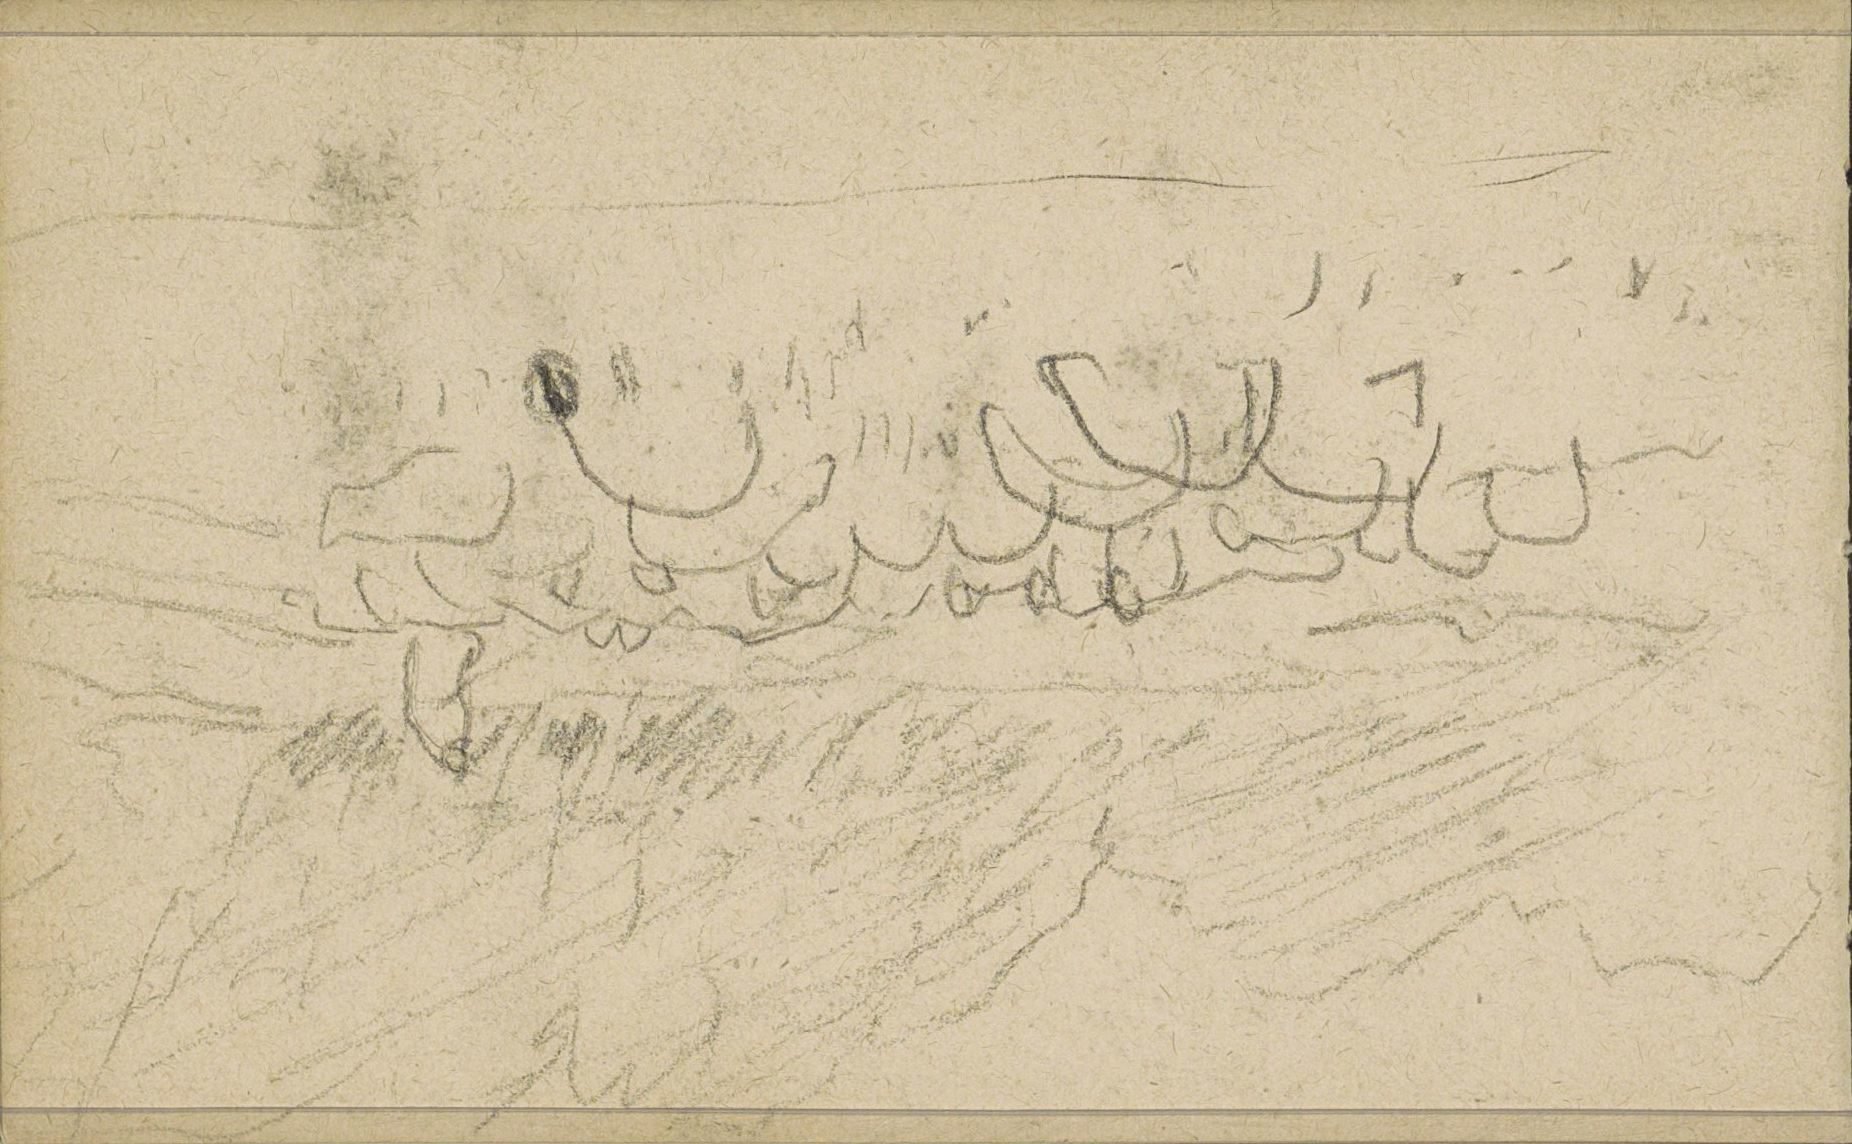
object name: sketchbook leaf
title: Herder met een kudde schapen in een landschap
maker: anton mauve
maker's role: draughtsman, painter, print maker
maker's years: 1838-1888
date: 1876-1888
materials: chalk, paper, pencil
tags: herding, herdsman, herdswoman, shepherd, shepherdess, cowherd, etc., sheep, herd, flock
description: Blad 16 verso uit een schetsboek met 34 bladen.